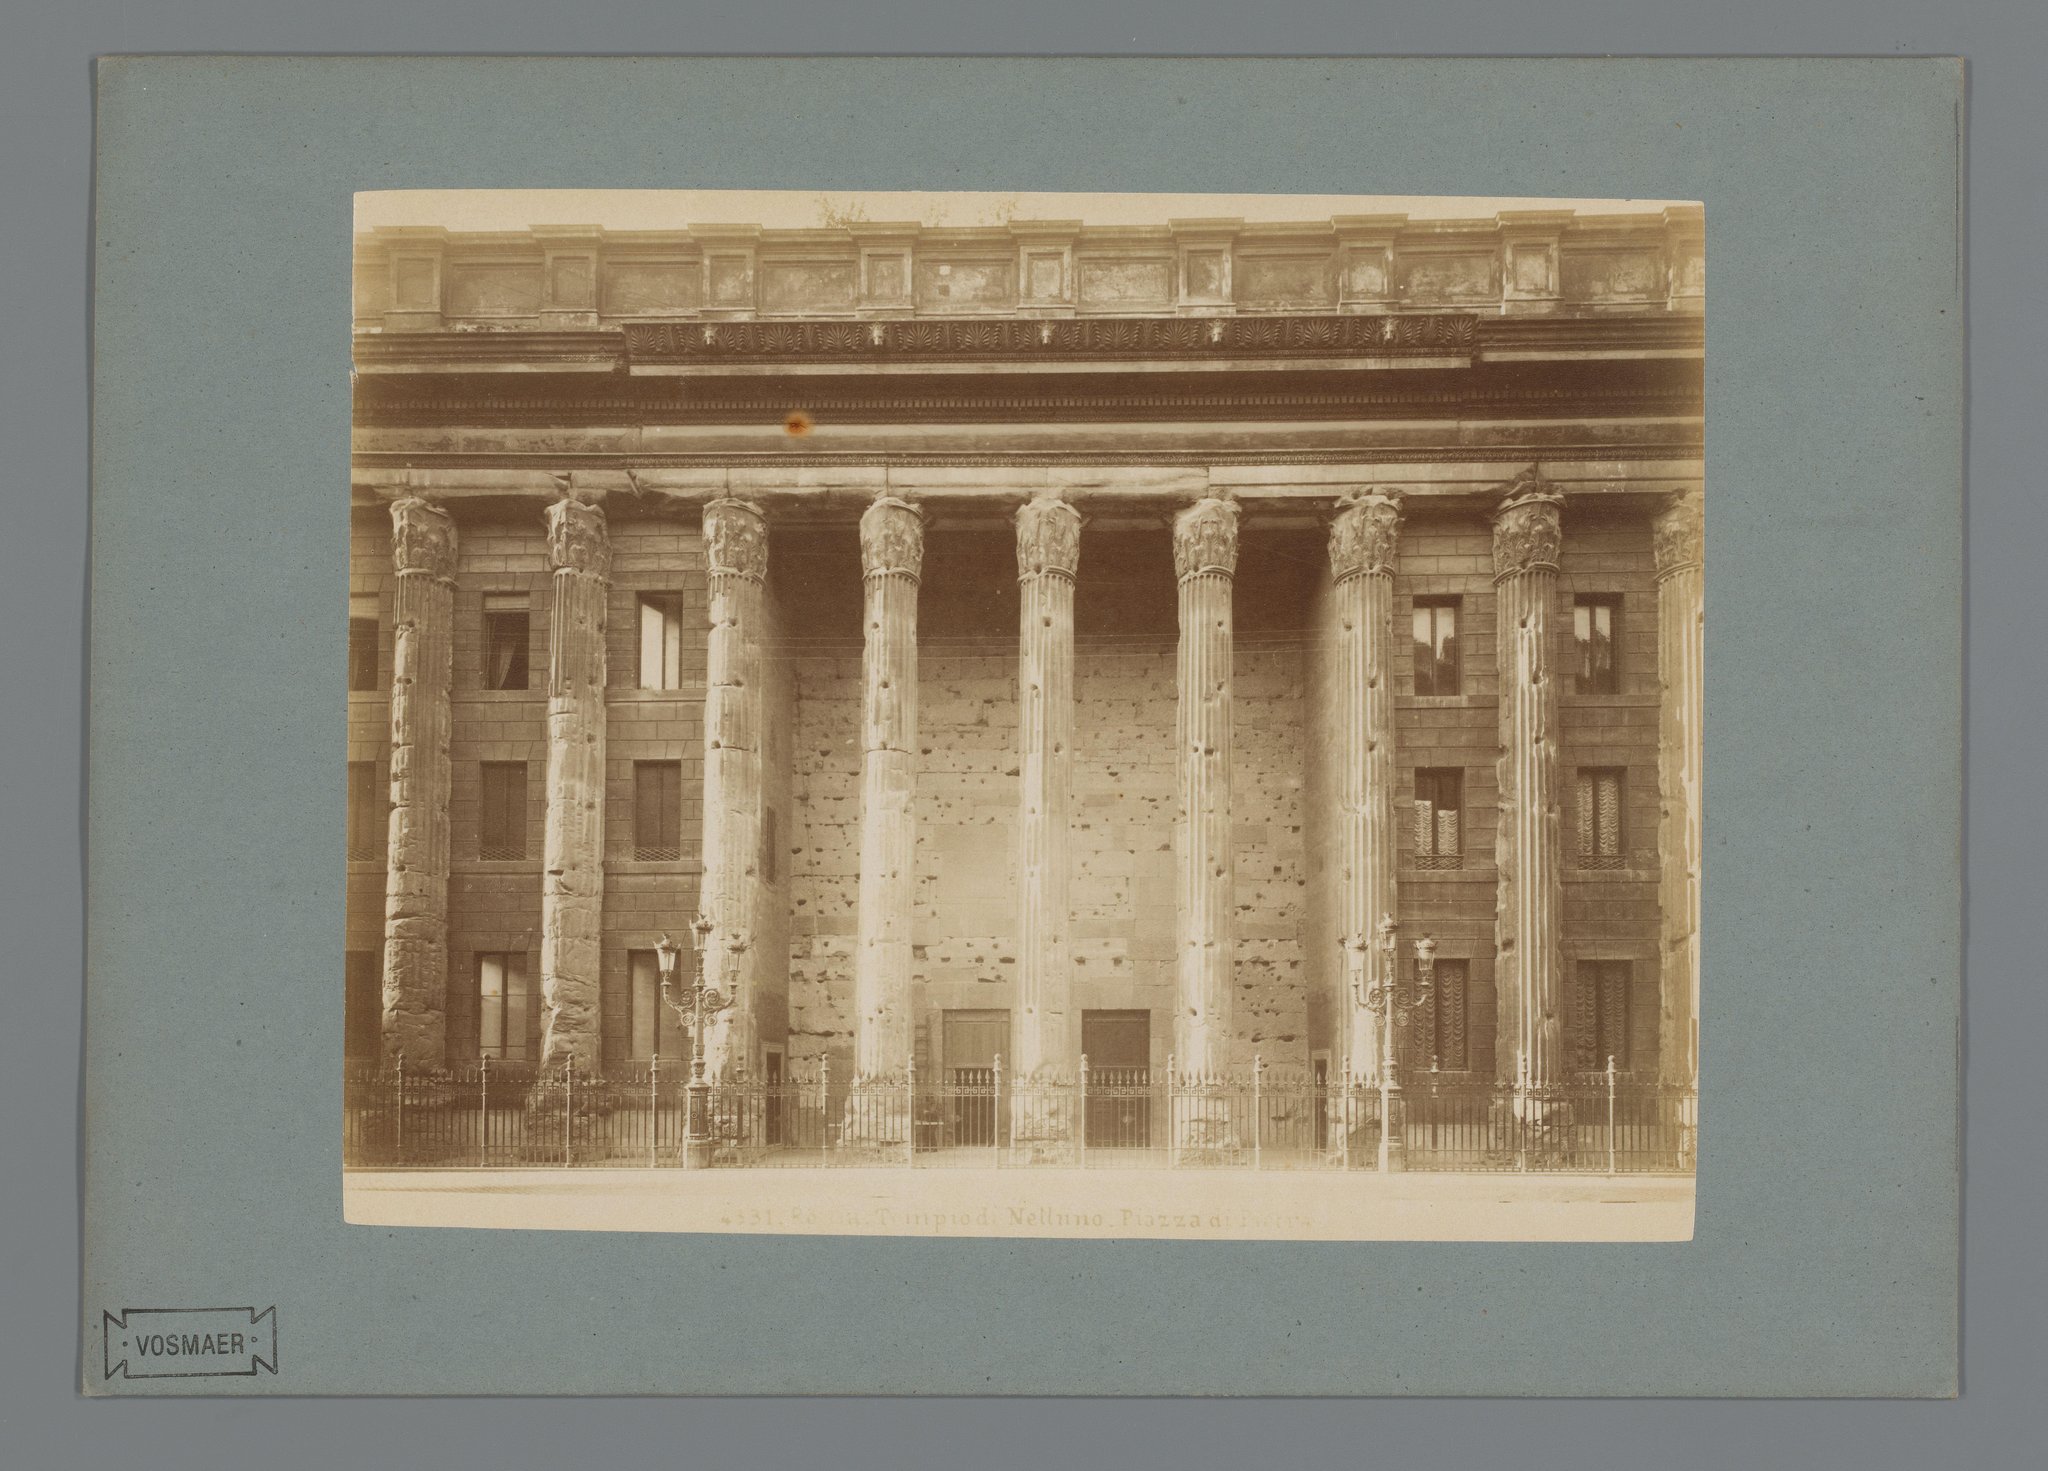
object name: photograph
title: Tempel van Hadrianus te Rome, Italië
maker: Anonymous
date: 1851-1890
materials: cardboard, paper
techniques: albumen print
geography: rome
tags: temple, shrine ~ roman religion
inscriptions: collector's mark: ‘VOSMAER’, number: ‘4331’